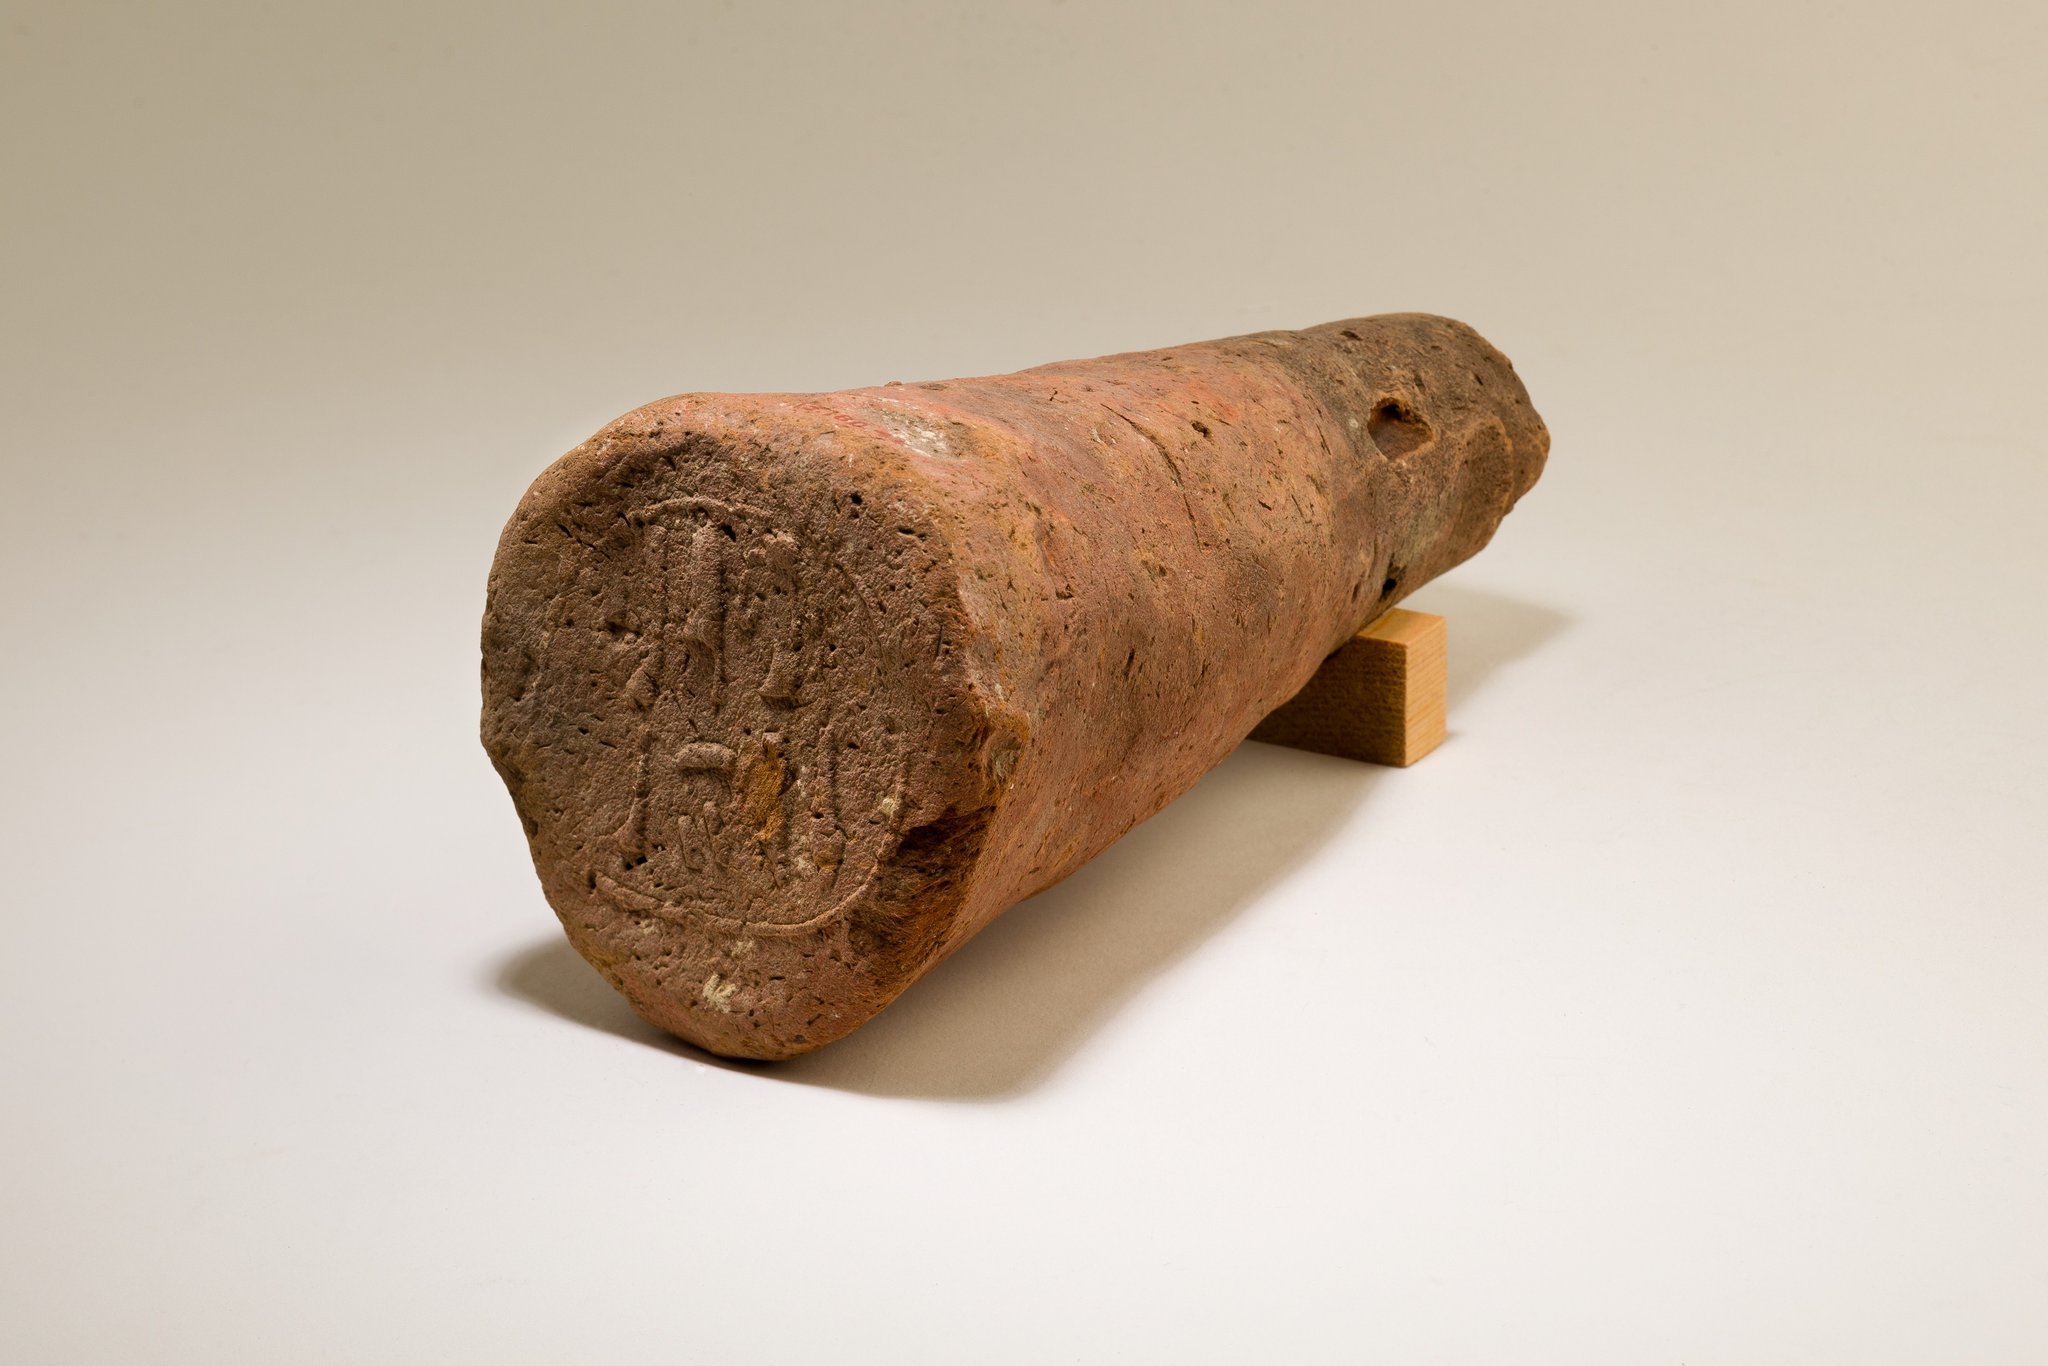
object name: cone, circular impression, ibety, herald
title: Funerary Cone of the Herald Ibety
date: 1550-1295 BCE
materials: pottery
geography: egypt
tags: hieroglyphs